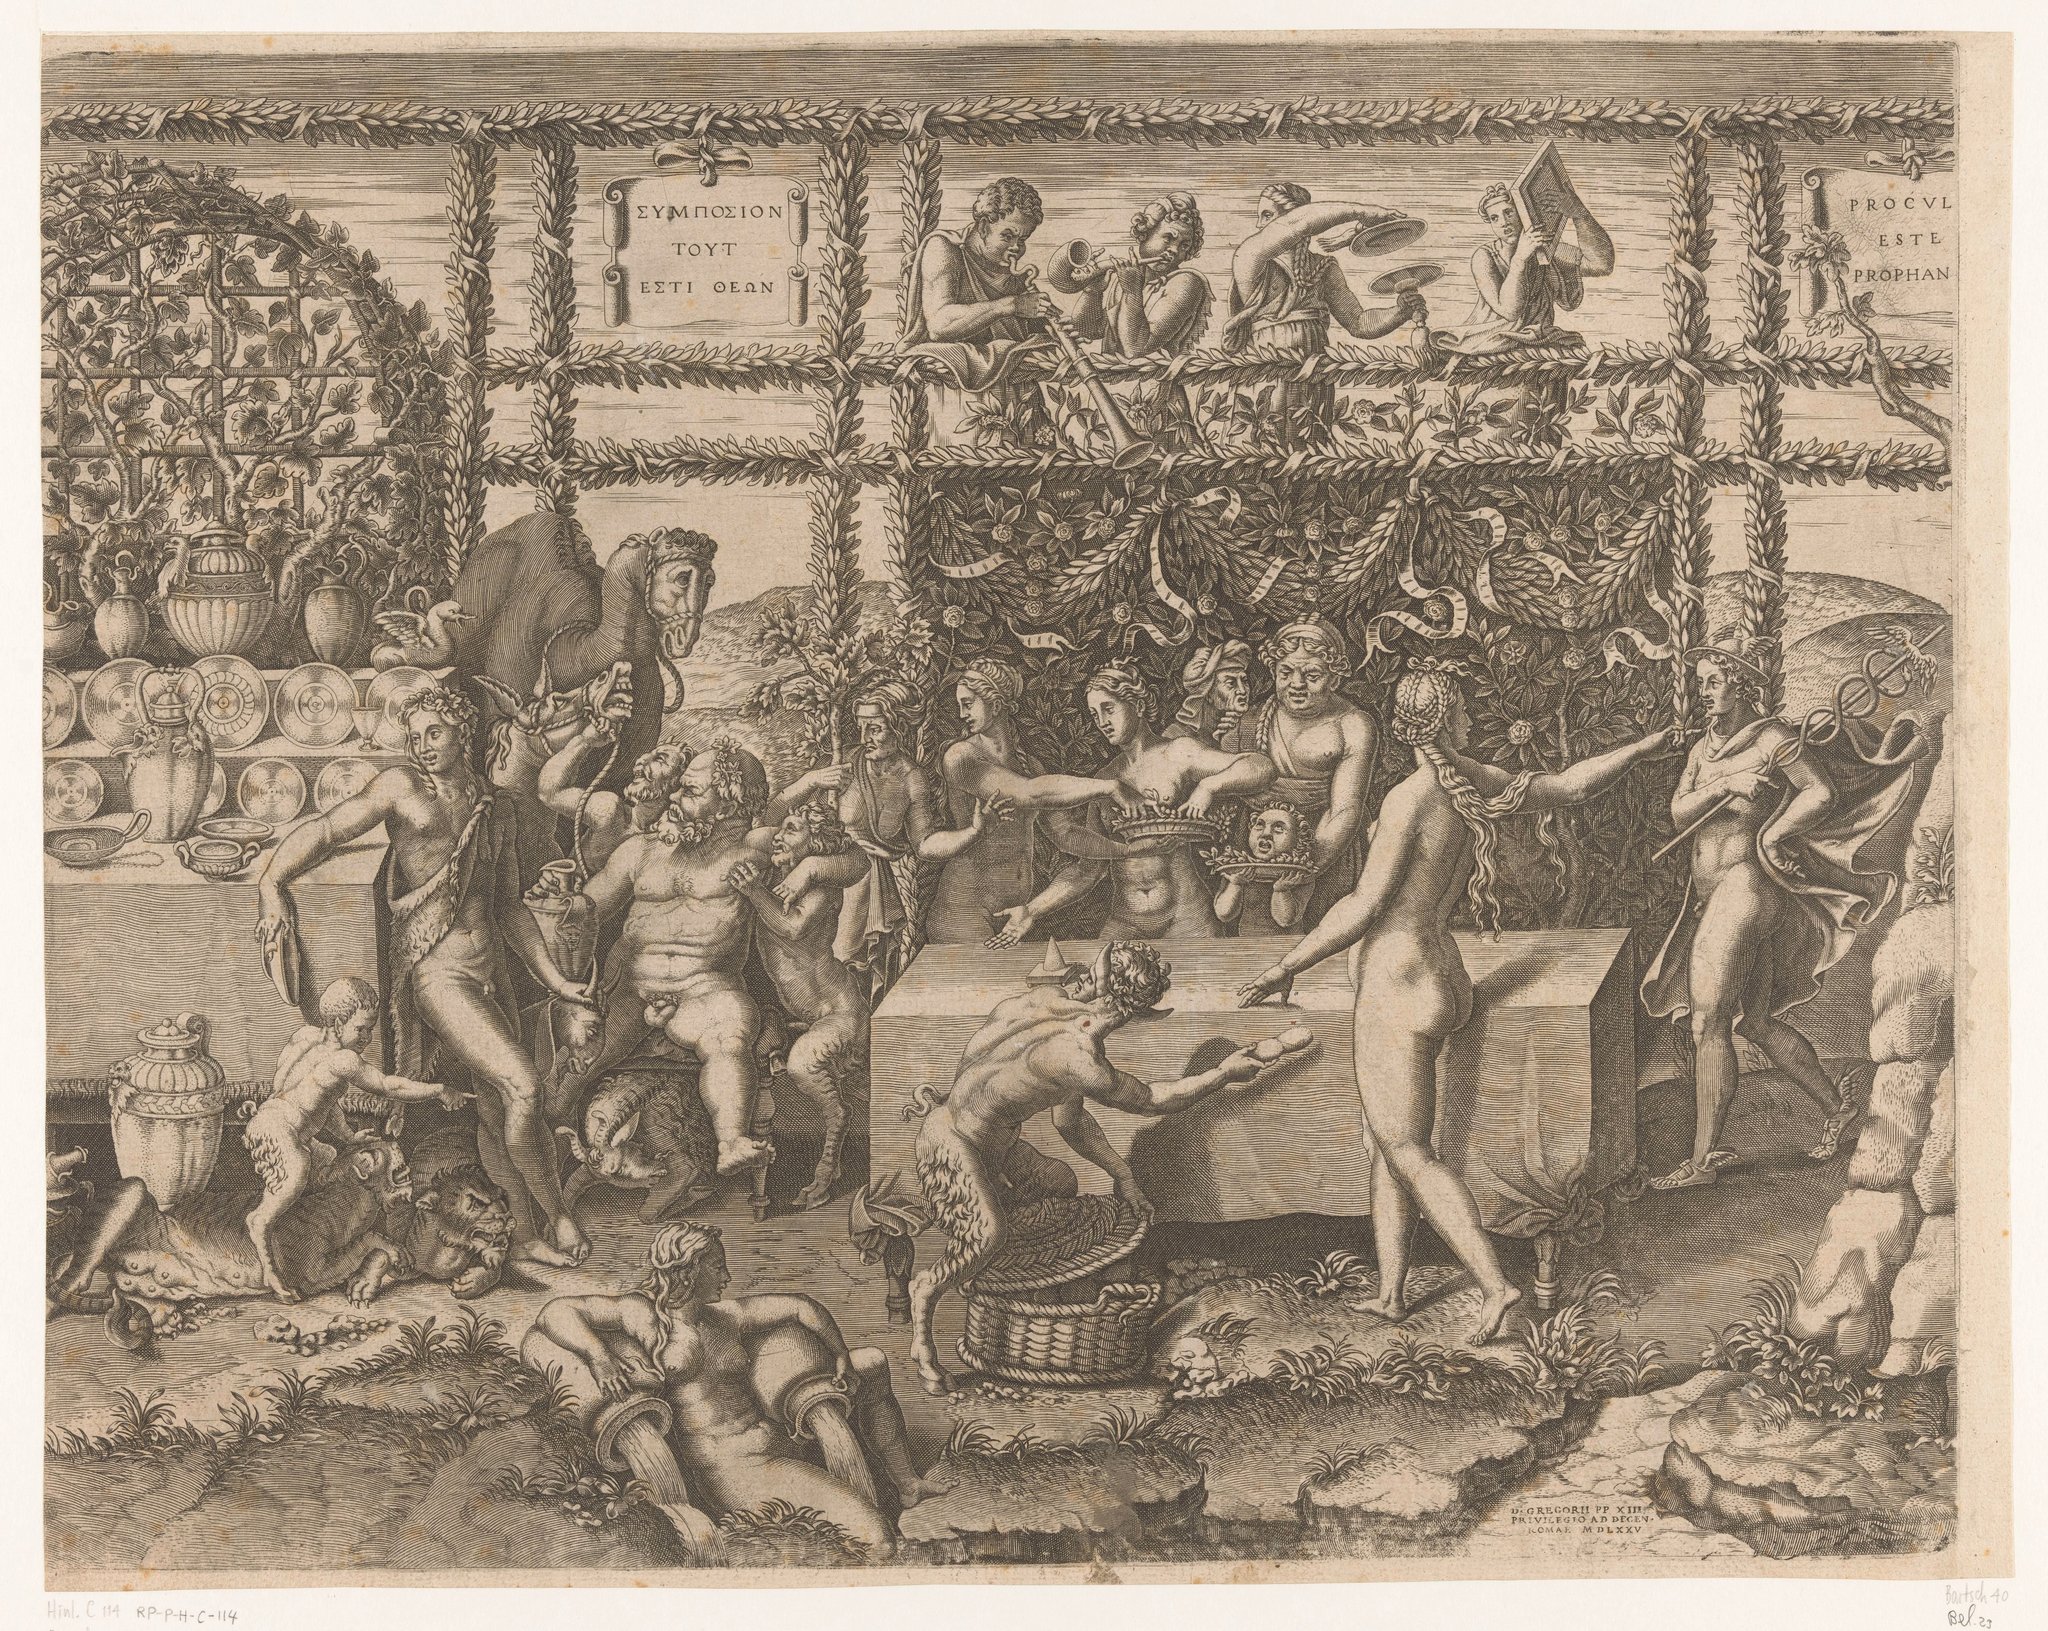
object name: print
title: Voorbereidingen voor het huwelijksfeest van Amor en Psyche (middendeel)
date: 1575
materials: paper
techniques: engraving, etching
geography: italy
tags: hoofed animals: dromedary, (story of) bacchus (dionysus), liber, (story of) mercury (hermes), horn, trumpet, cornet, trombone, tuba, graces (charites), generally three in number; 'gratie' (ripa), satyr(s) (in general)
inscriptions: collector's mark: Lugt 10, collector's mark: ‘Hinloopen’, collector's mark: Lugt 11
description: Links een met luxe serviesgoed gedekte tafel die staat onder een baldakijn begroeid met druivenranken. In het midden zit Bacchus omringd door saters, een ezel en een dromedaris. Rechts geeft Mercurius opdracht aan de gratiën om de tafel voor het banket te versieren. Daarboven vier muzikanten.